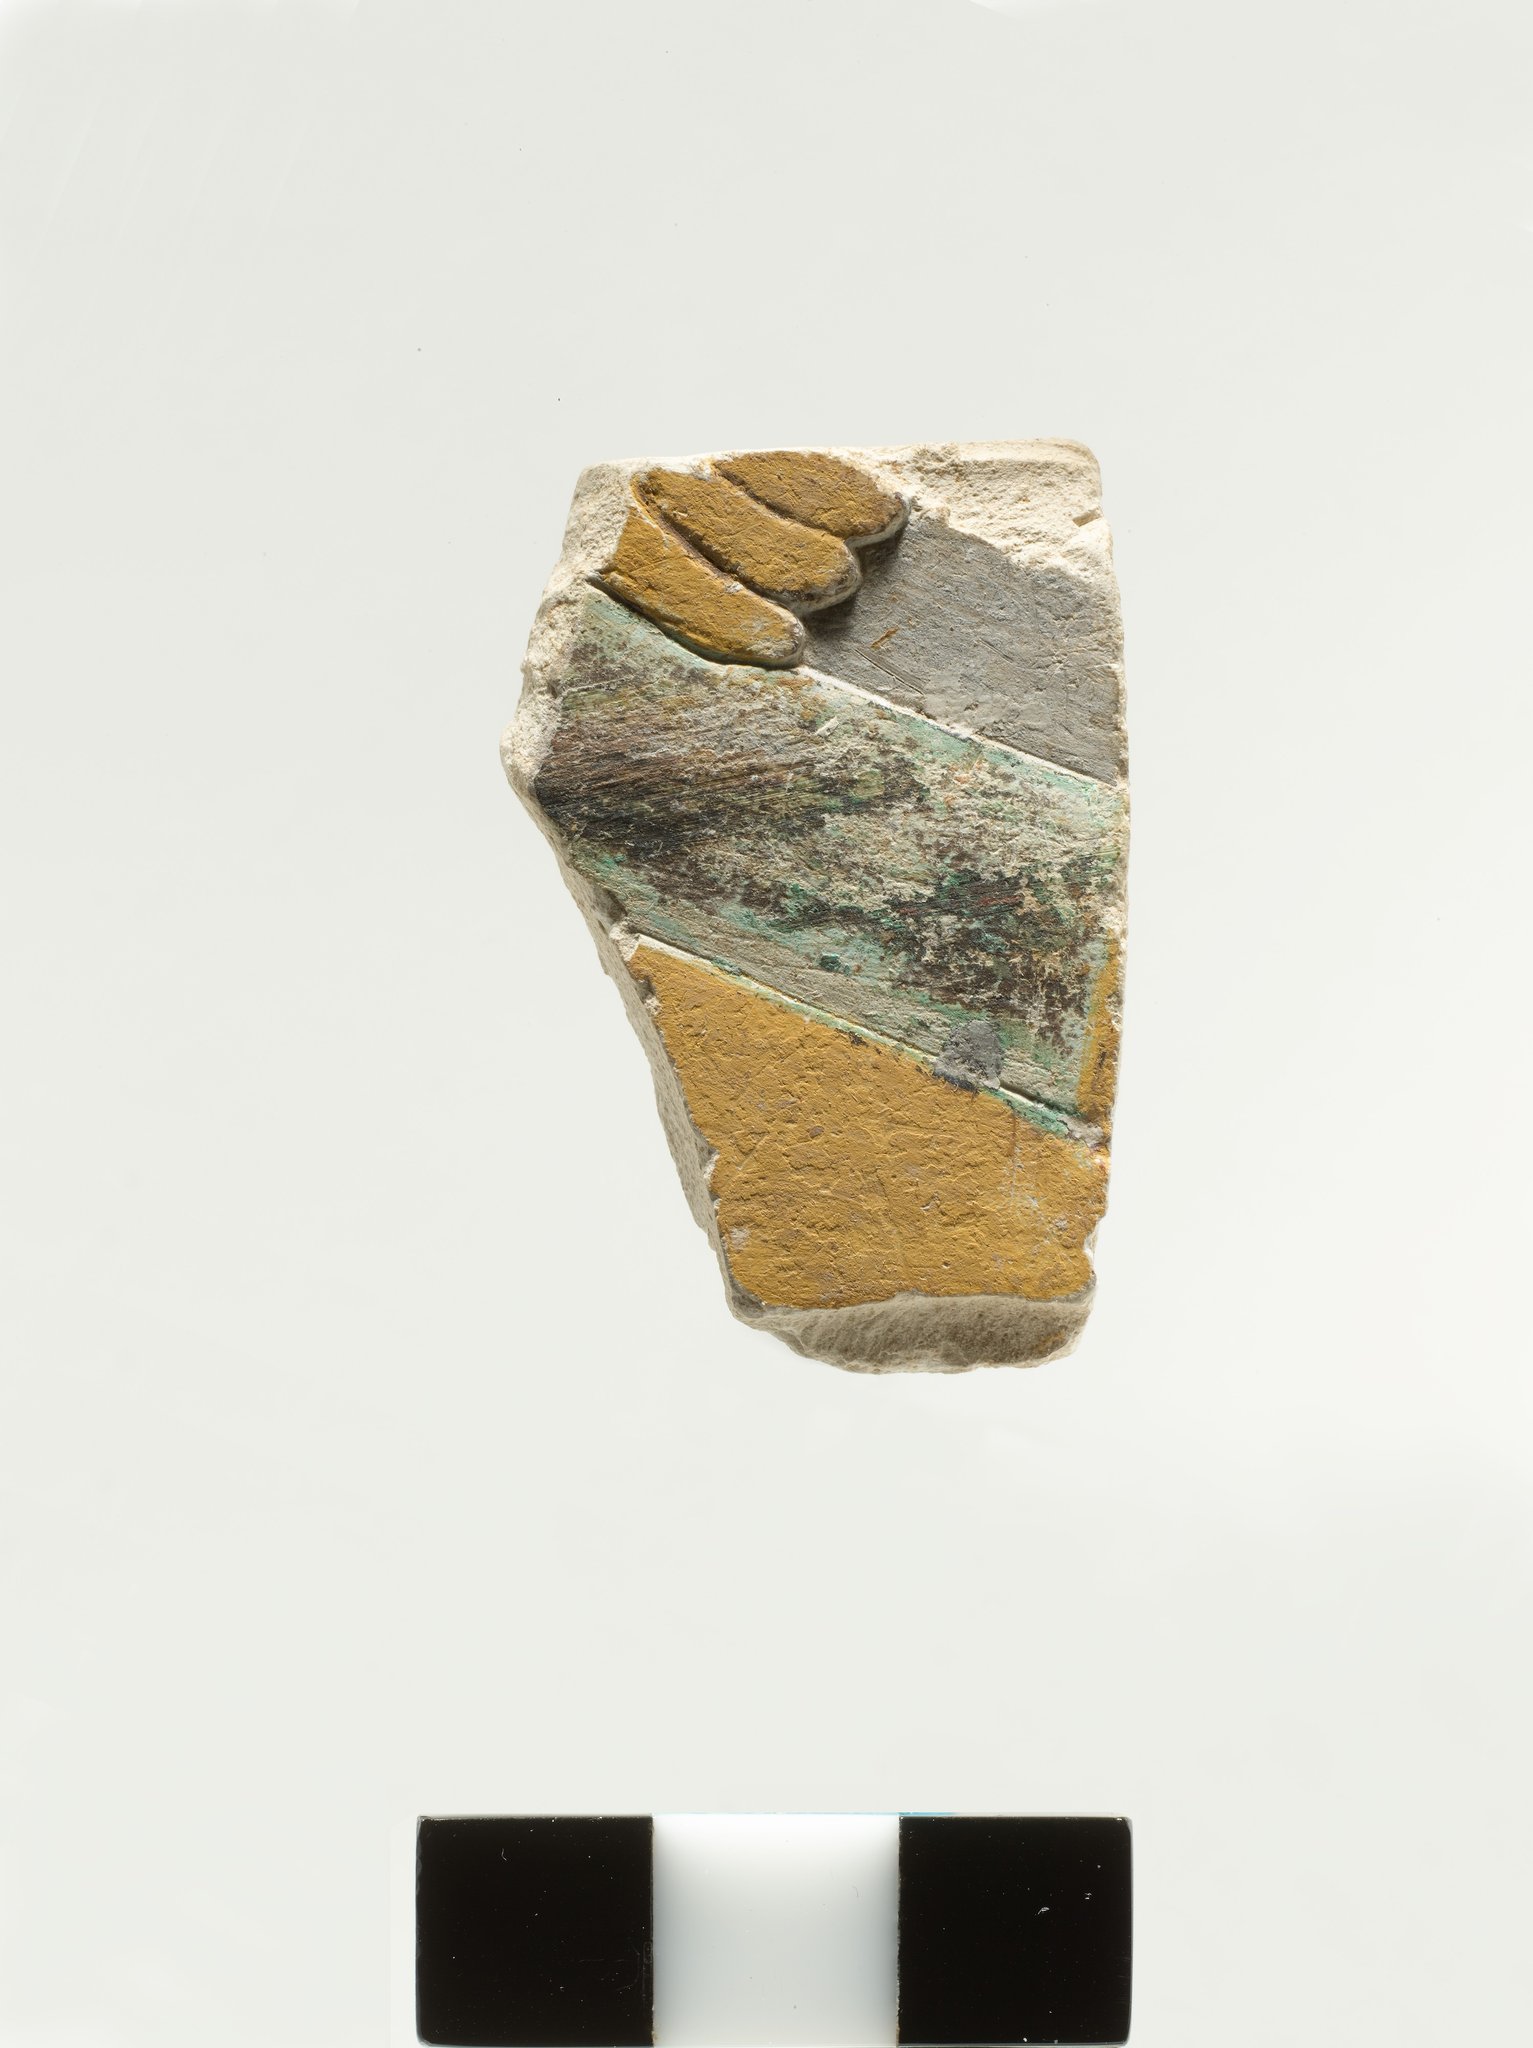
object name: relief fragment, tomb of meketre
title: Reliefs from the tomb of Meketre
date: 1981-1975 BCE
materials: limestone, paint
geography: egypt